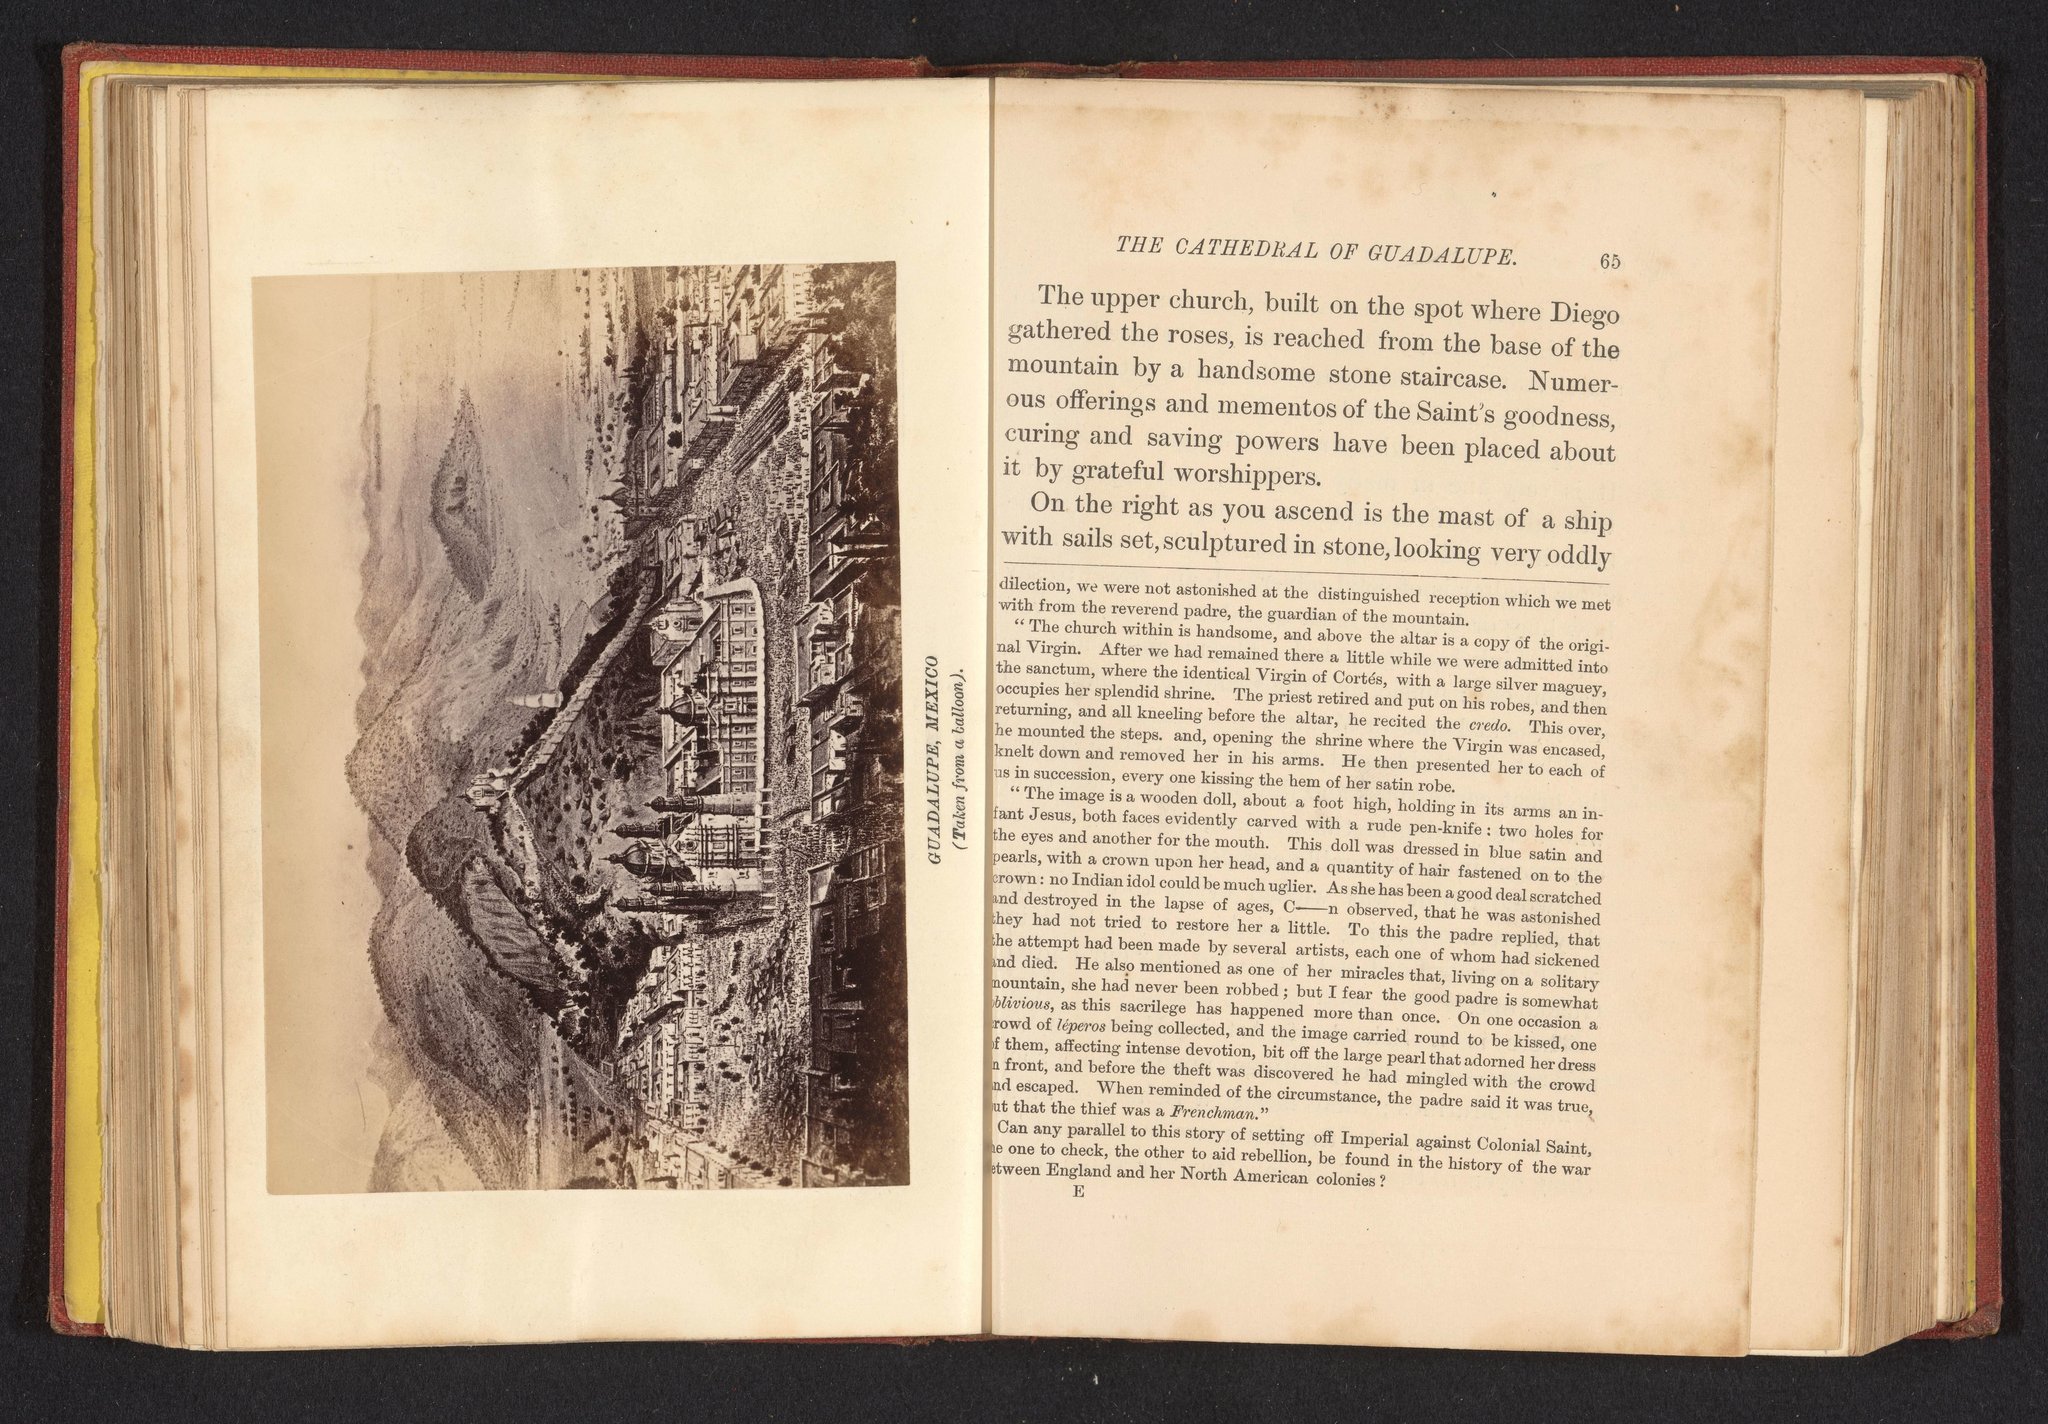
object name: photograph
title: Guadelupe, Mexico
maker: Anonymous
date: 1870-1880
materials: photographic support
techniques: albumen print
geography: mexico city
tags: city-view in general; 'veduta', church (exterior)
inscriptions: inscription: ‘(Taken from a balloon)’